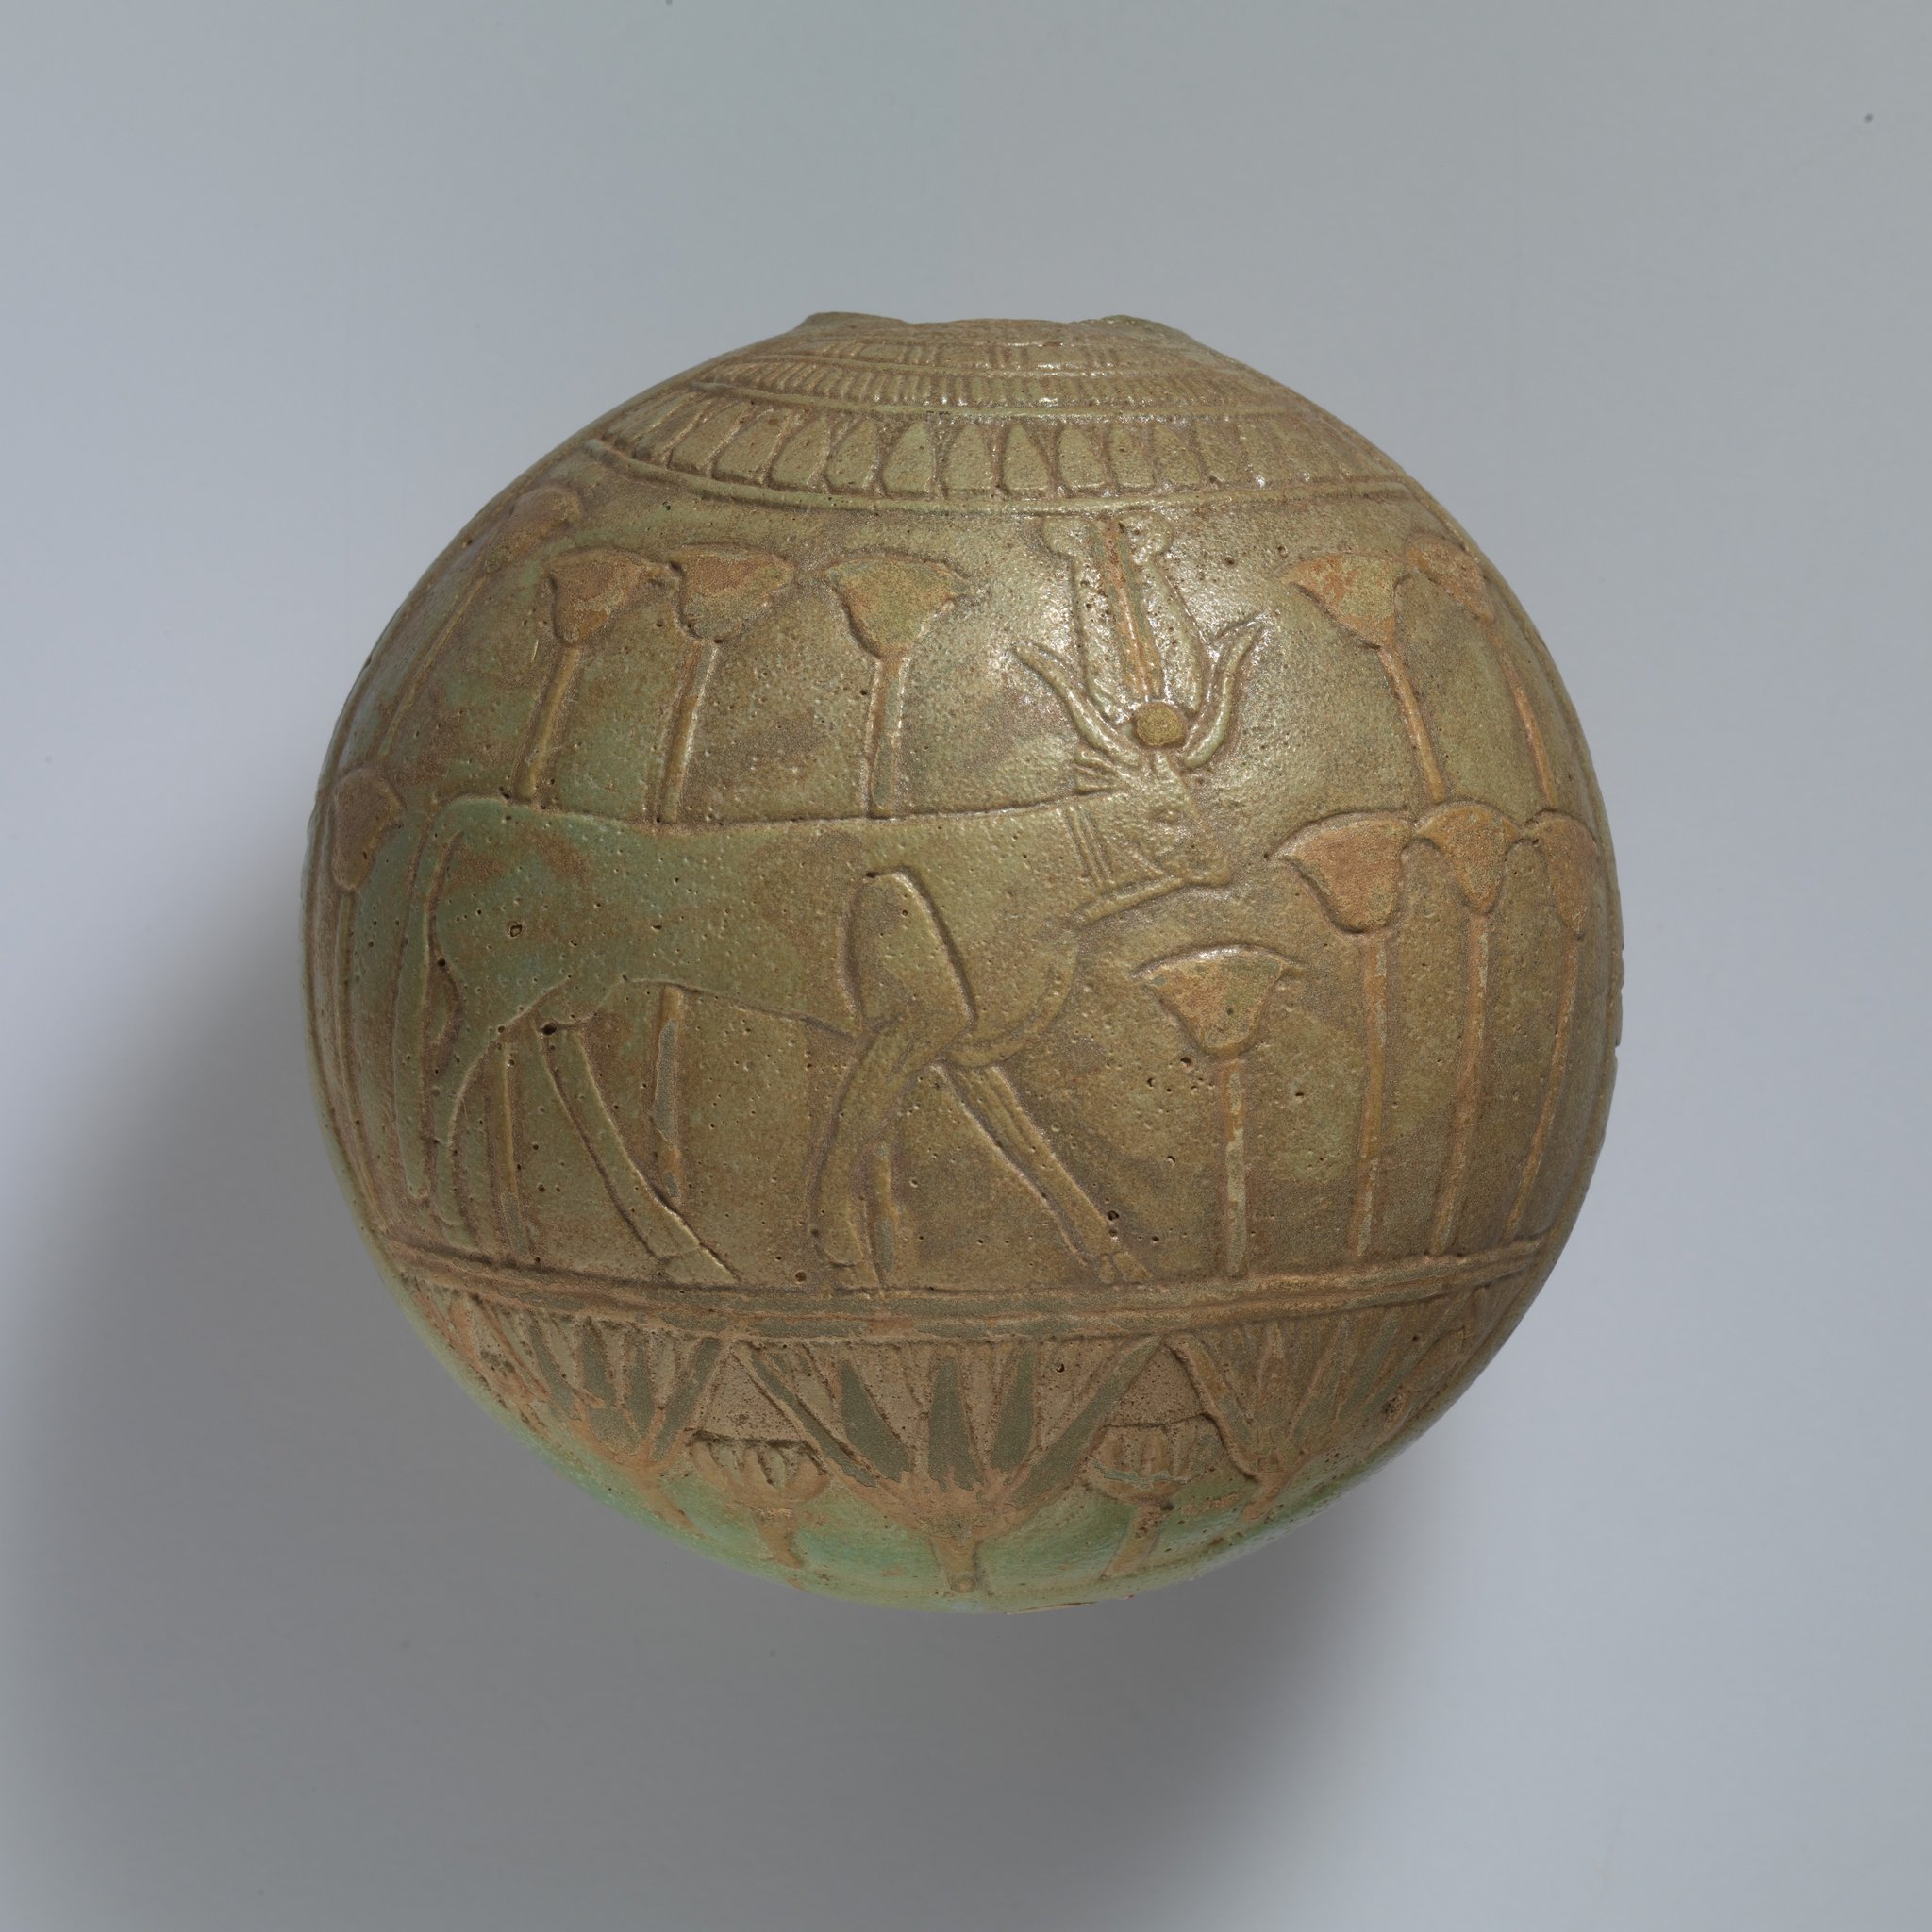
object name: new year's bottle with cow goddess nebethetepet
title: Relief-decorated Lentoid Bottle ("New Year's Bottle"); Horus falcon in marshes on one side; cow goddess in marshes on the other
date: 630 BCE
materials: faience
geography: egypt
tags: horus,cows